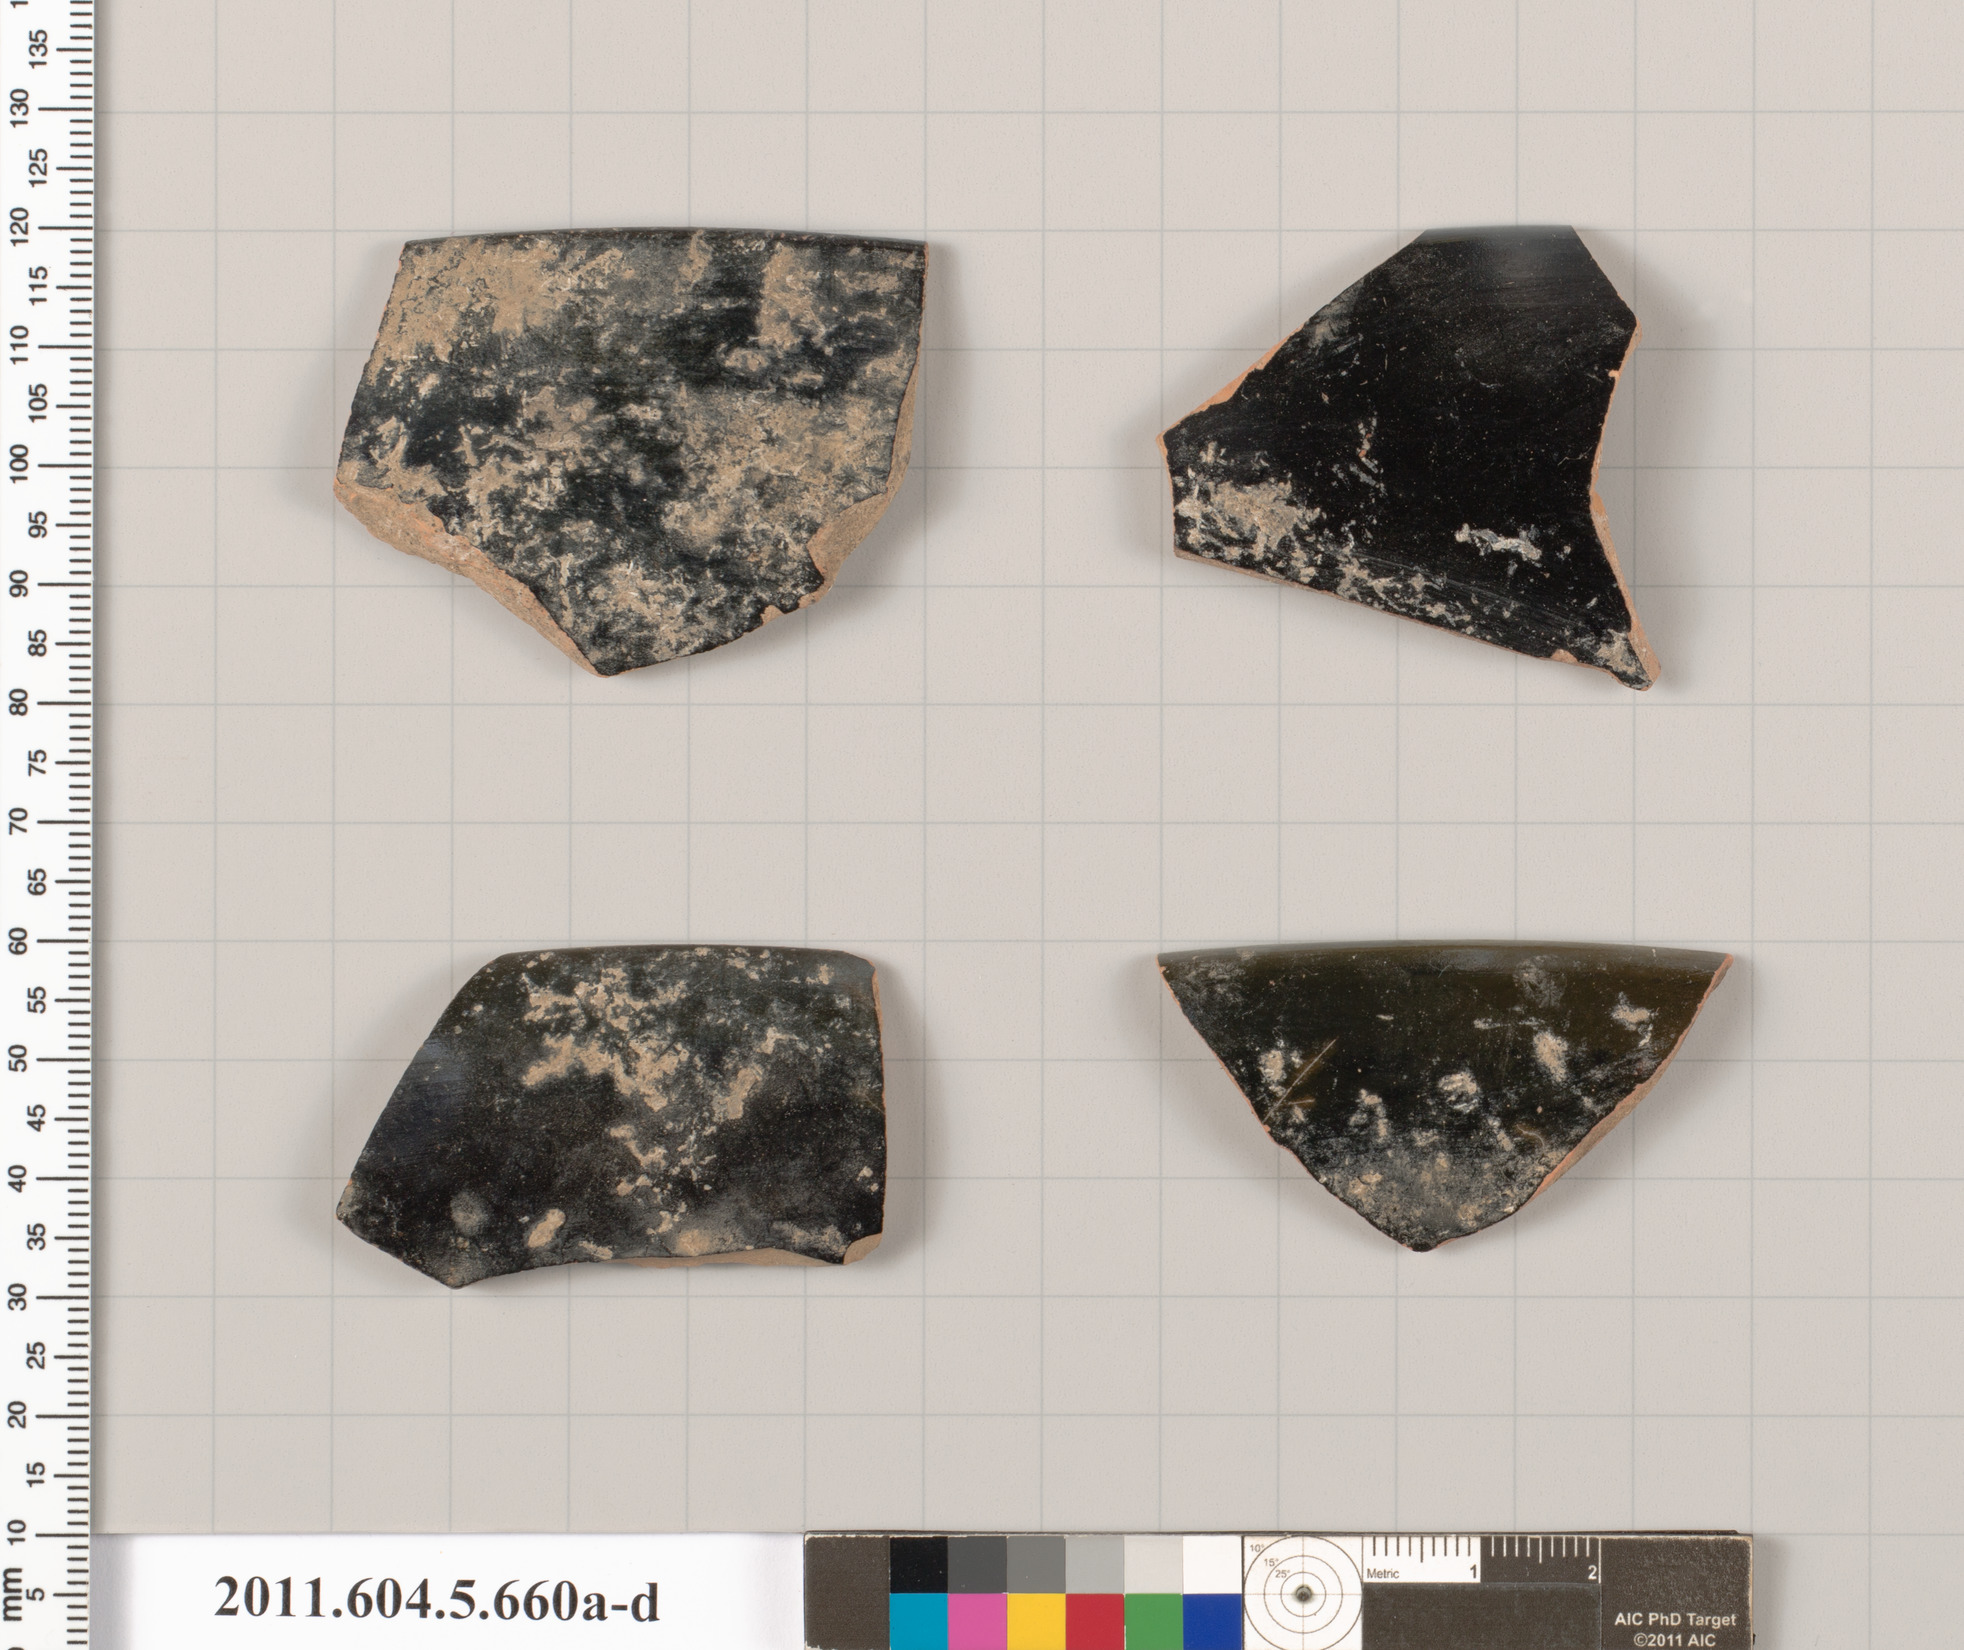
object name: kylix fragment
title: Terracotta rim fragments of kylikes (drinking cups)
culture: greek, attic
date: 600-401 BCE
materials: terracotta